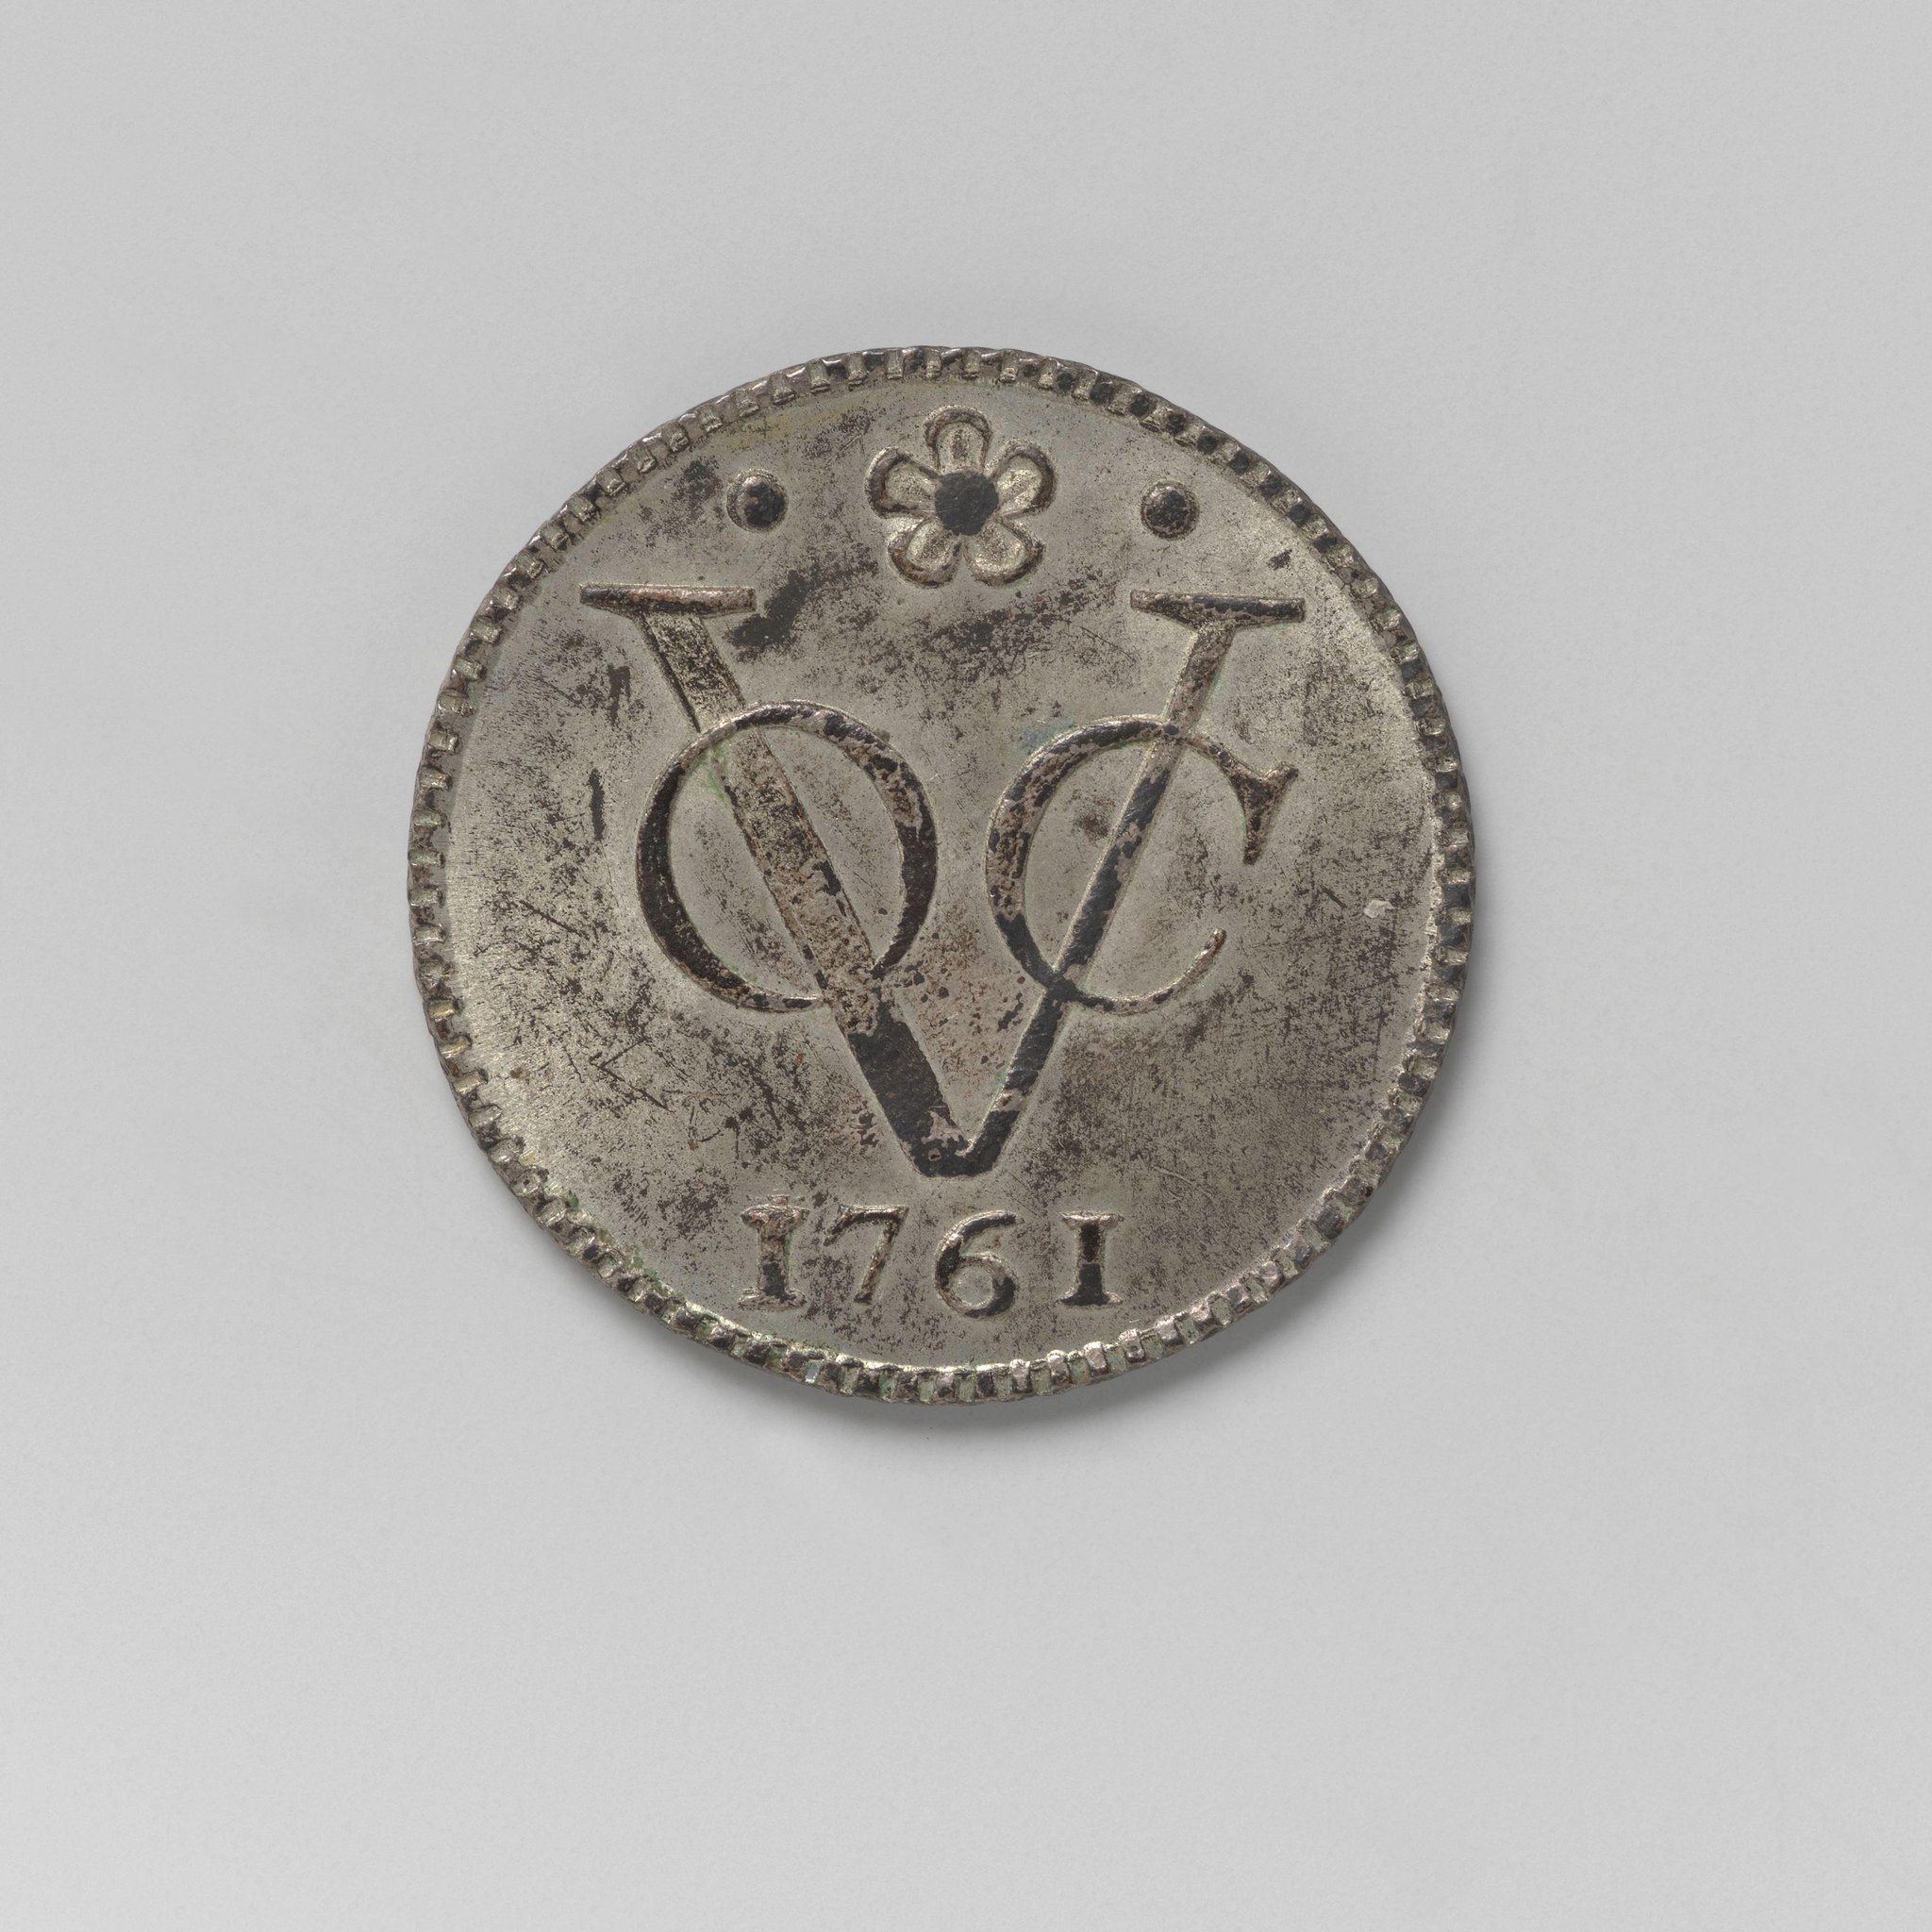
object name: coin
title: Zilveren afslag van een ½ duit van de VOC uit Holland, 1761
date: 1761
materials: silver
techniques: striking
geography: dordrecht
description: Zilveren munt. Voorzijde: gekroond wapenschild van Holland. Keerzijde: monogram van de VOC, waarboven muntteken en waaronder jaartal. Kabelrand.